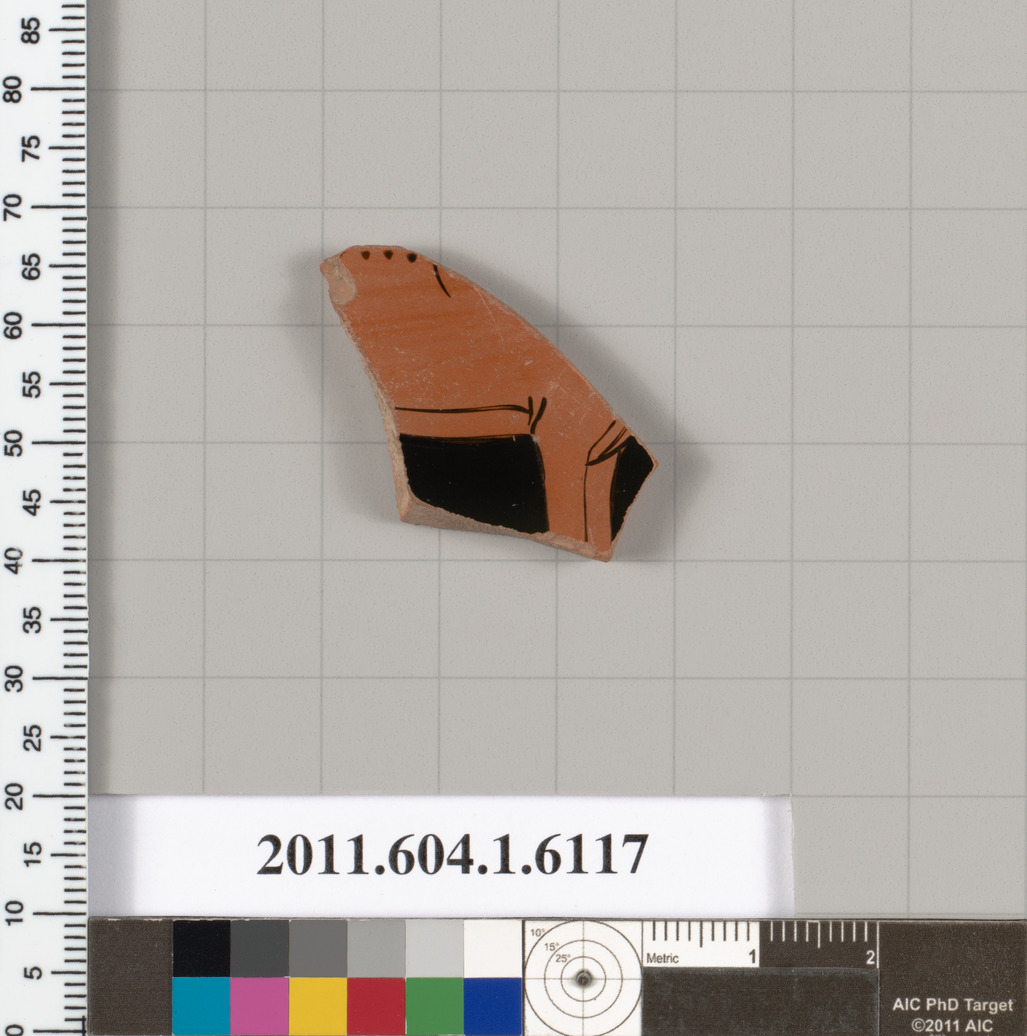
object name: kylix fragment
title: Terracotta fragment of a kylix (drinking cup)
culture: greek, attic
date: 510-490 BCE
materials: terracotta